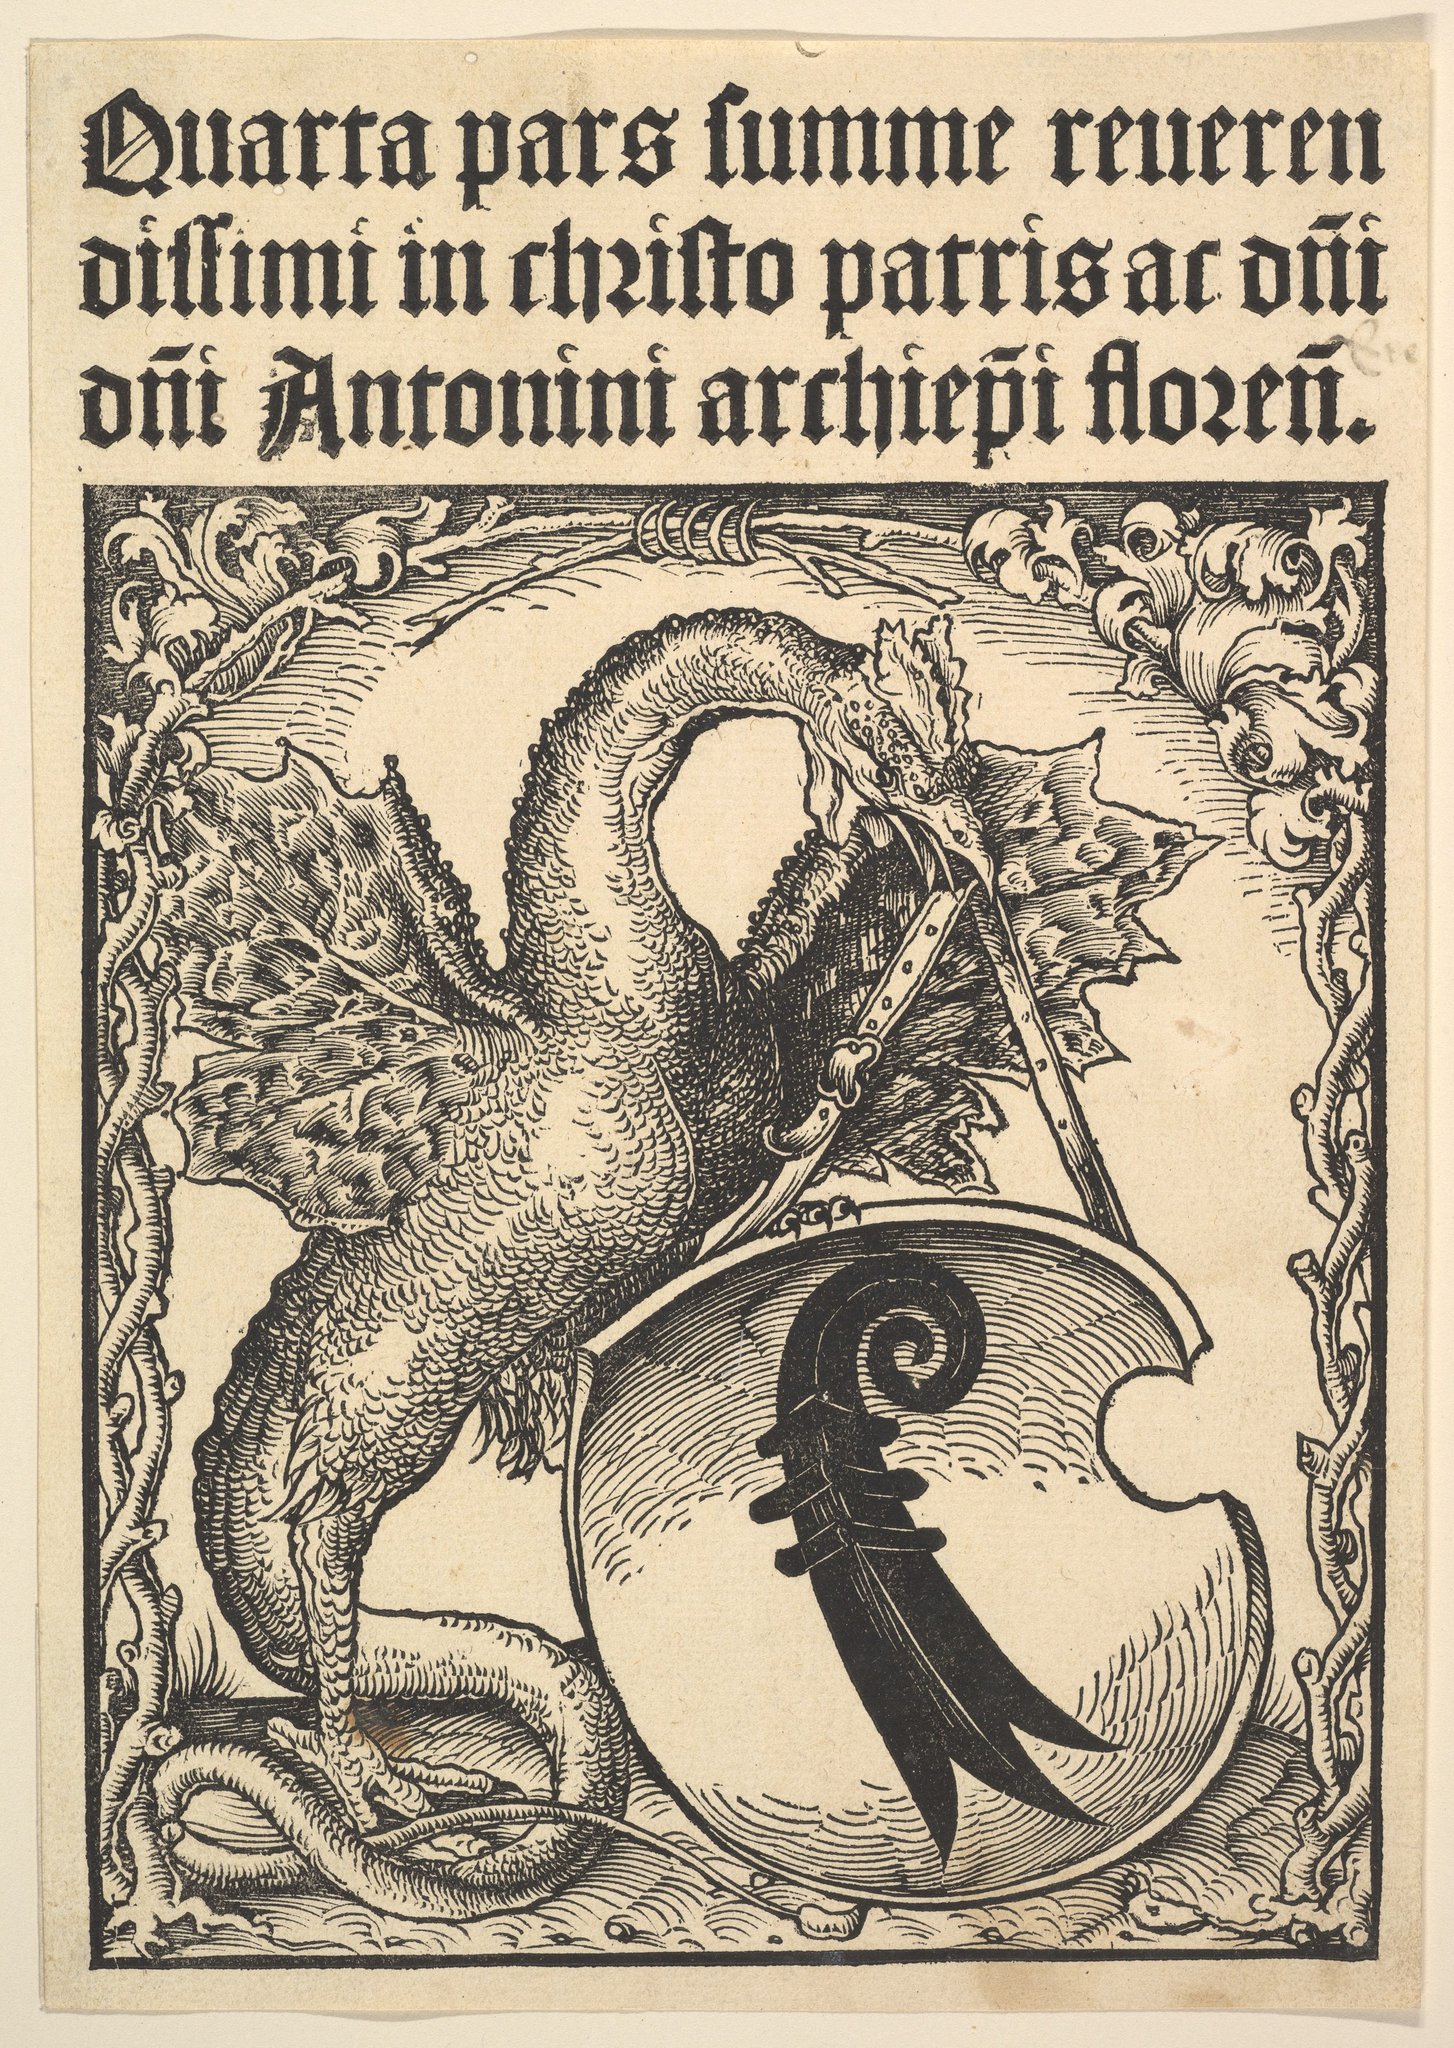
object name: print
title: Basilisk Supporting the Arms of the city of Basel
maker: master ds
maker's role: artist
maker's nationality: swiss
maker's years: 1503-1515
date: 1511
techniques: woodcut